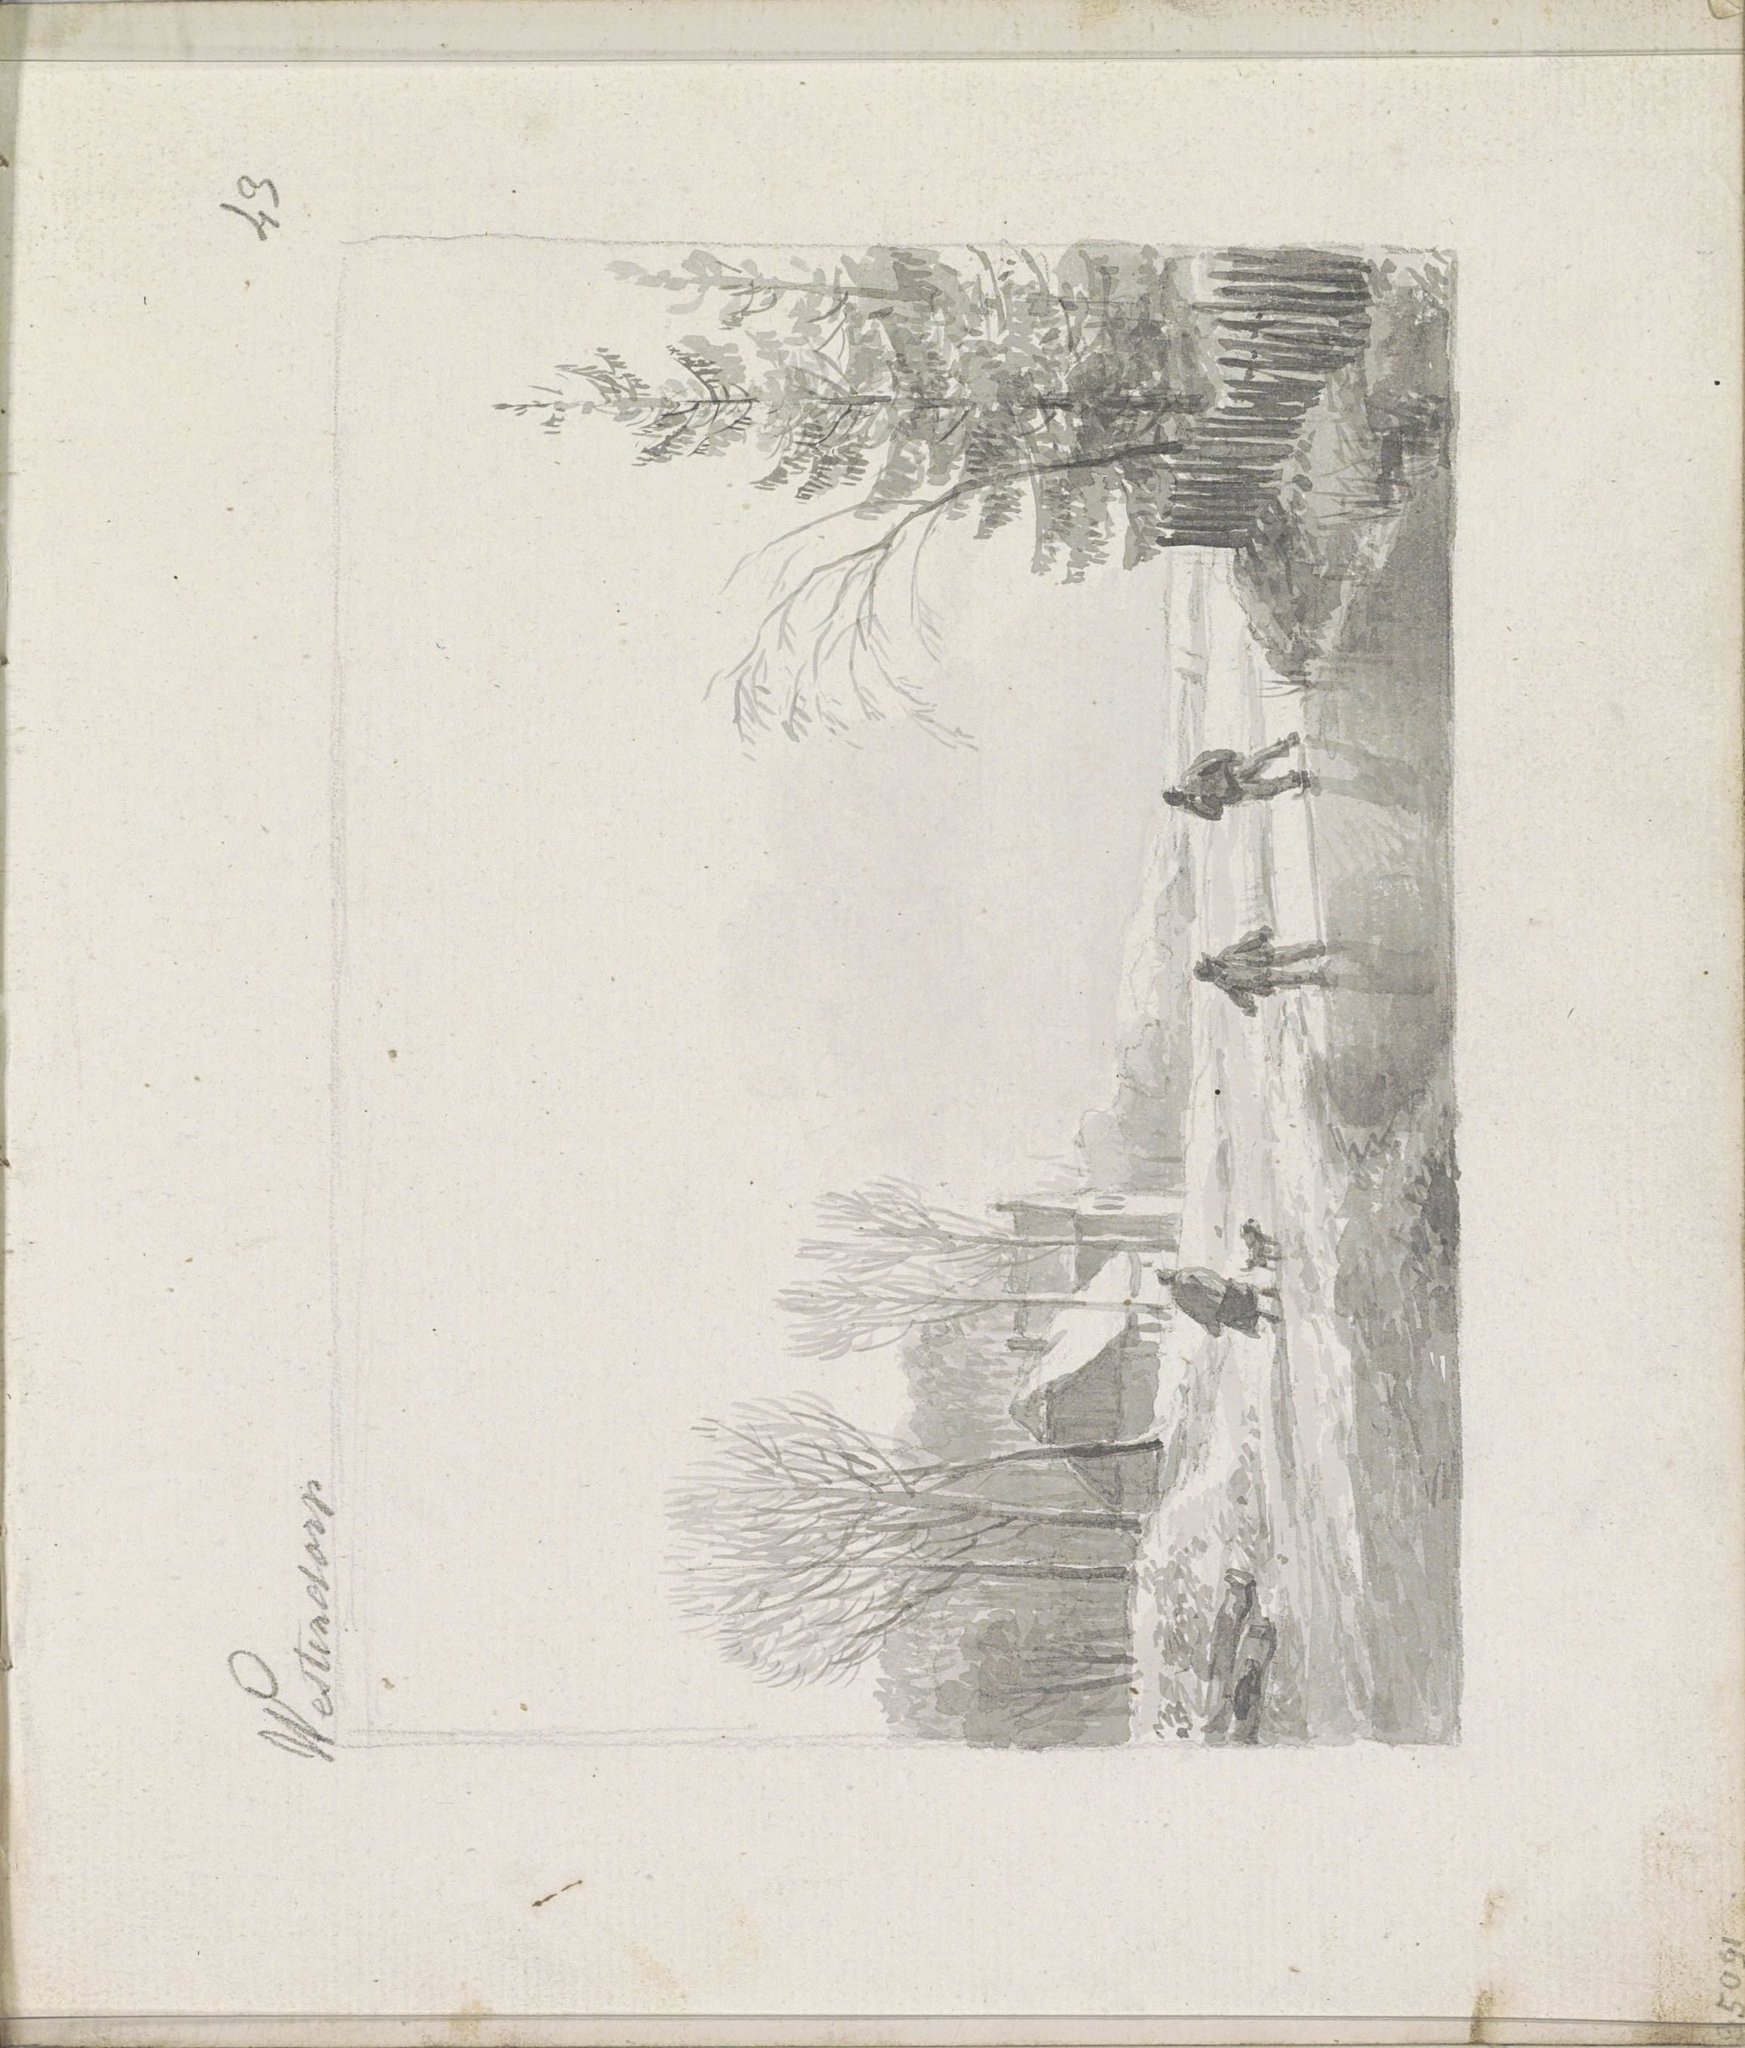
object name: sketchbook leaf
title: Schaatsers op een bevroren vaart langs een boerenwoning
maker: andreas schelfhout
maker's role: draughtsman, painter, print maker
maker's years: 1787-1870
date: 1825-1829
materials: paper, pencil, watercolor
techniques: brush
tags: frost, freezing weather, skates (winter sports)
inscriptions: number: ‘43/ 35091’, annotation: ‘Westendorp’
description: Blad 57 recto uit een schetsboek met 95 bladen.